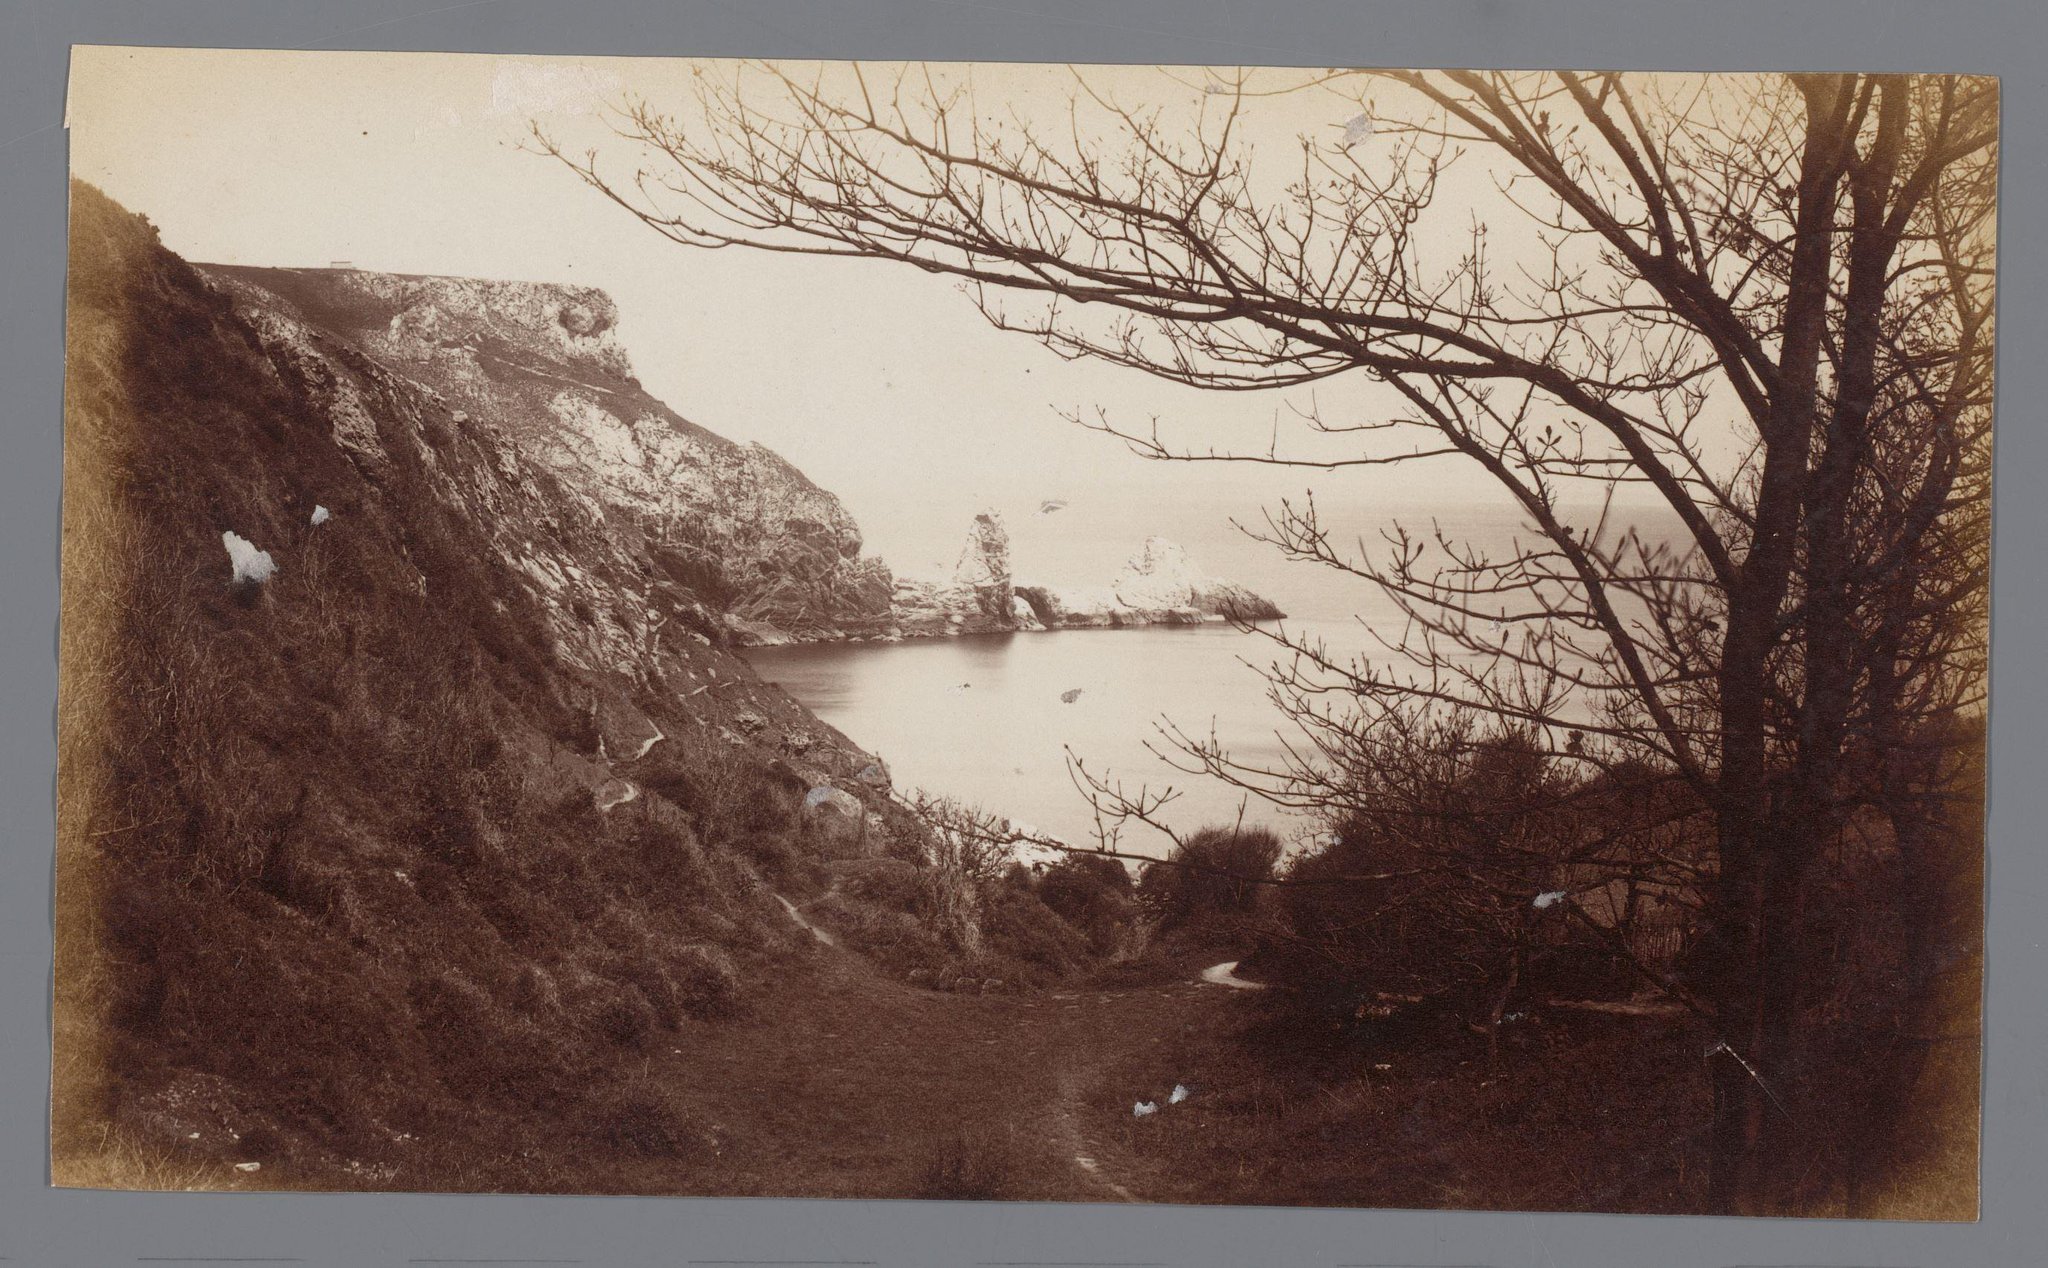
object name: photograph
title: Uitzicht over zee en kustlijn met rotsen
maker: Anonymous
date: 1875-1900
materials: photographic support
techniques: albumen print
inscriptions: number: ‘3151.’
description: Uitzicht over zee en kustlijn met rotsen.